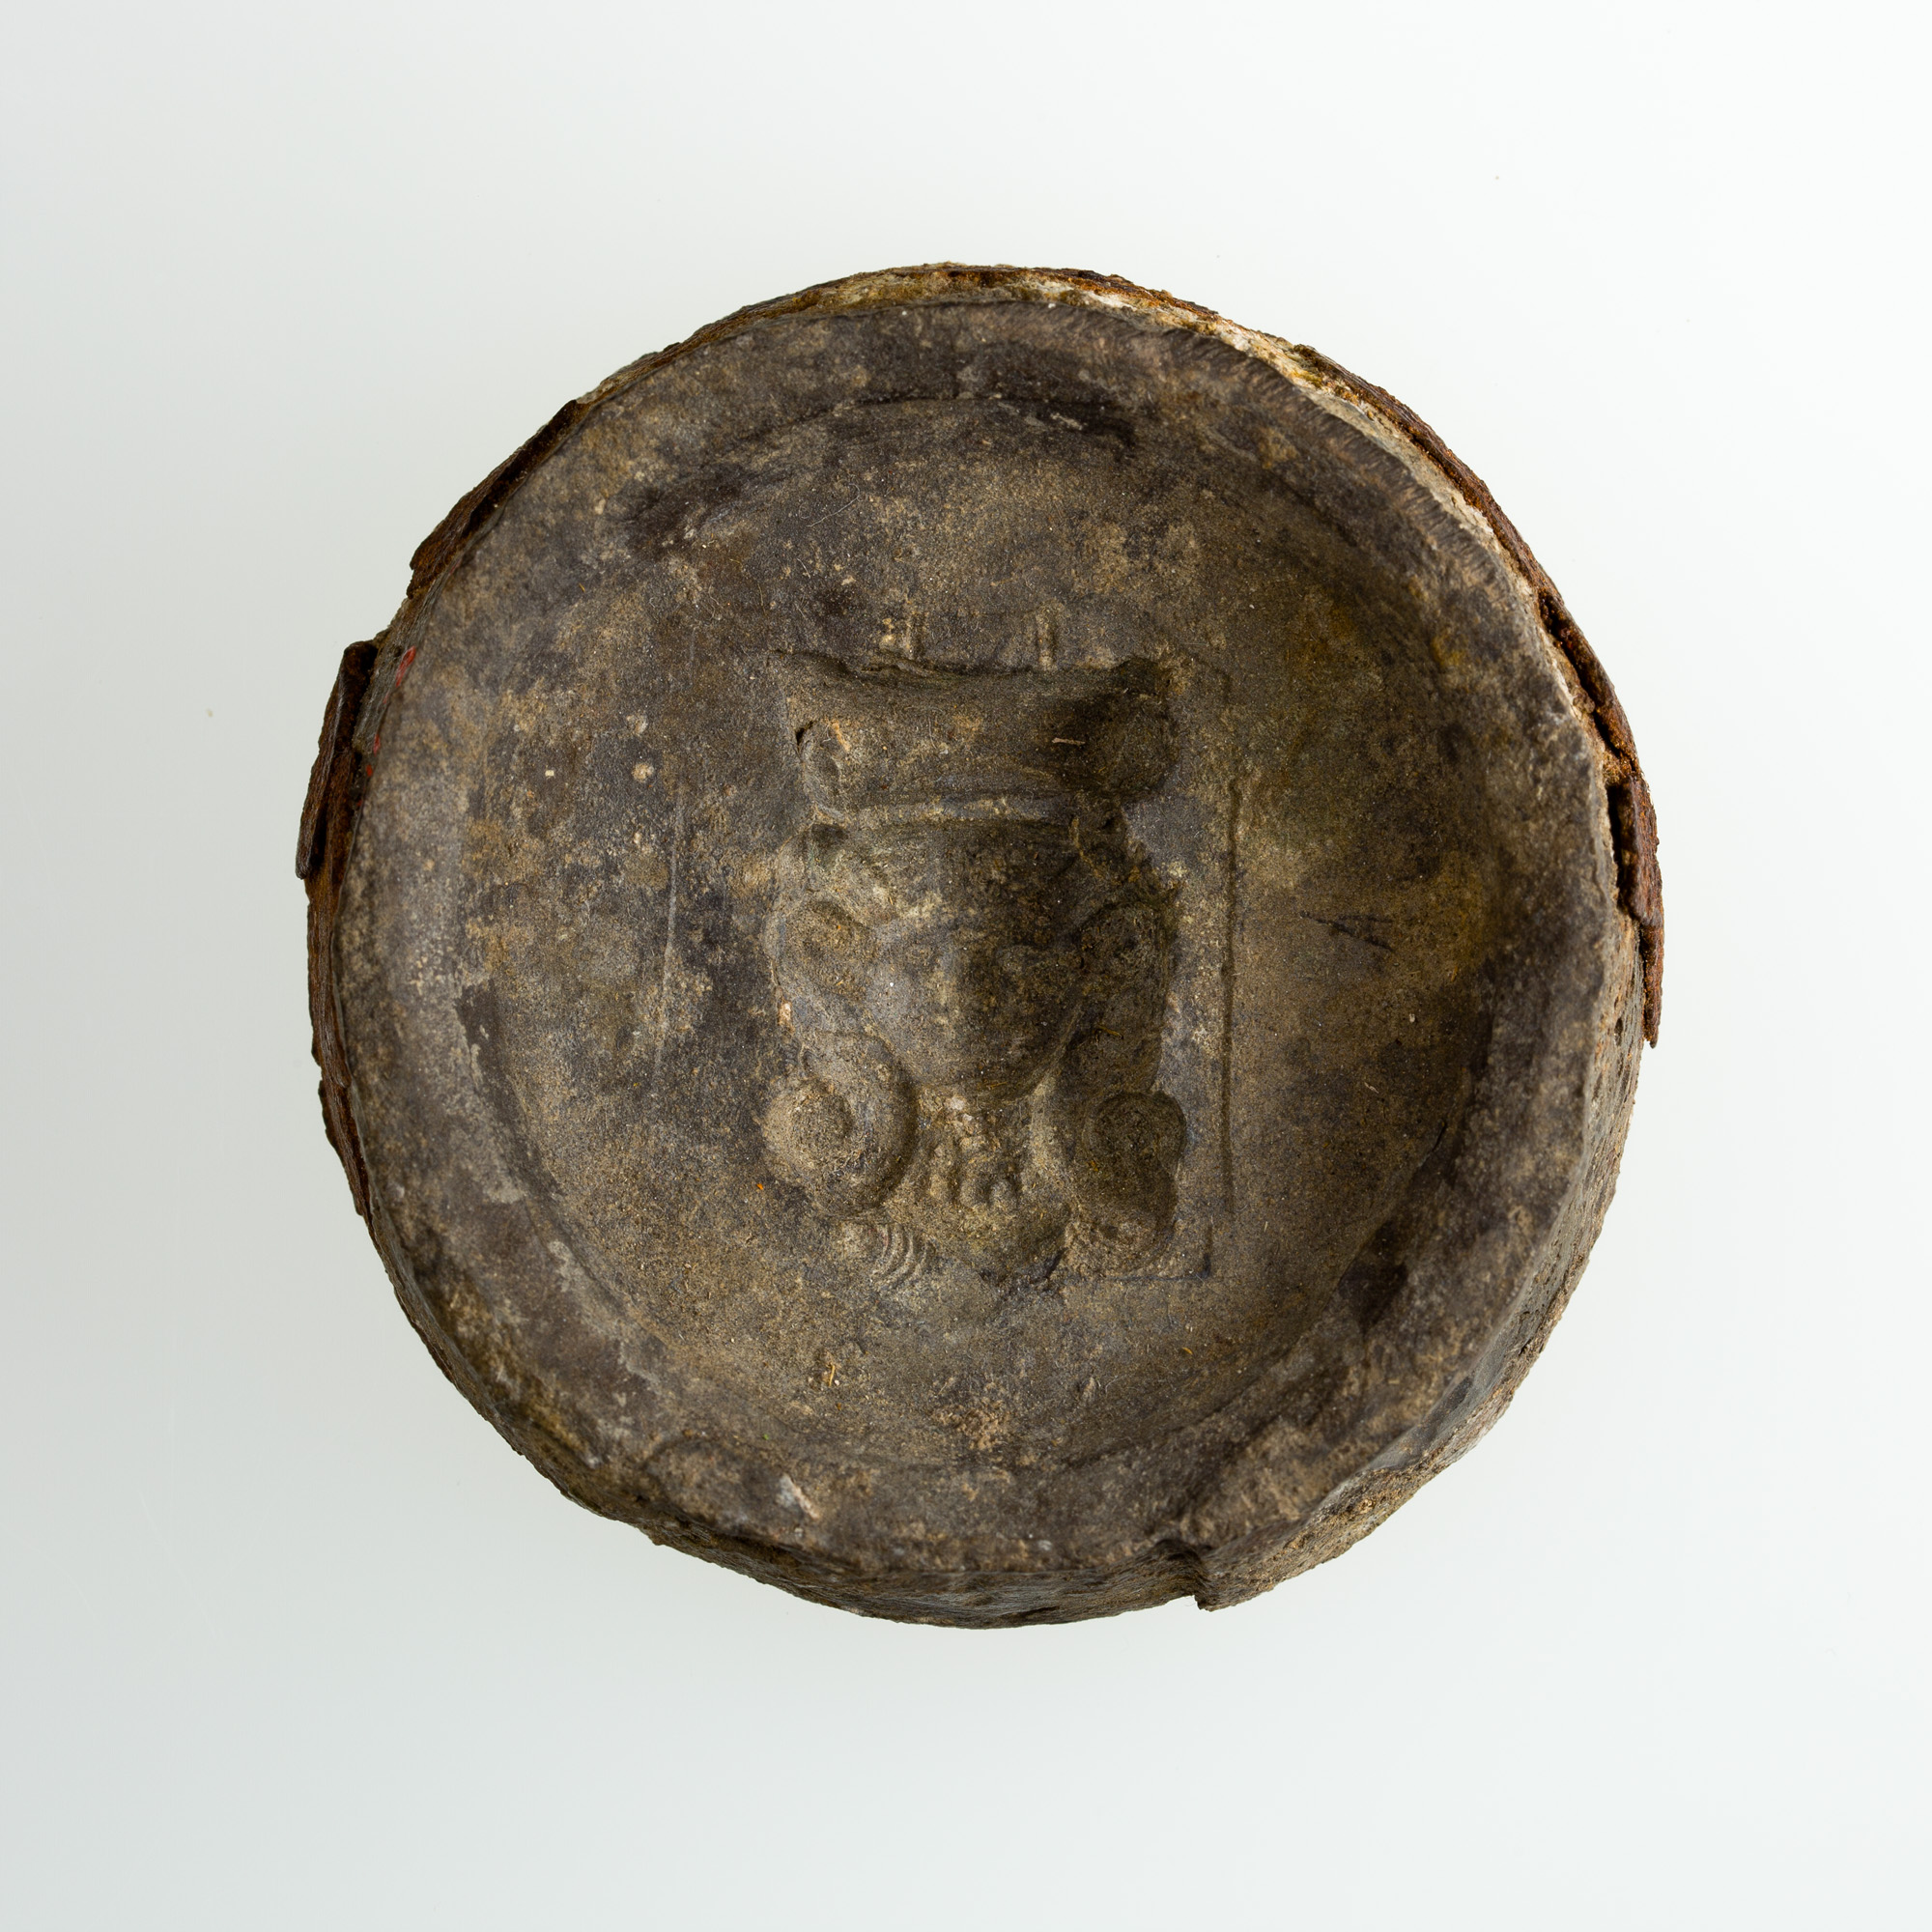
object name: mold, hathor head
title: Metal mold illustrating Hathor head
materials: lead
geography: egypt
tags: hathor